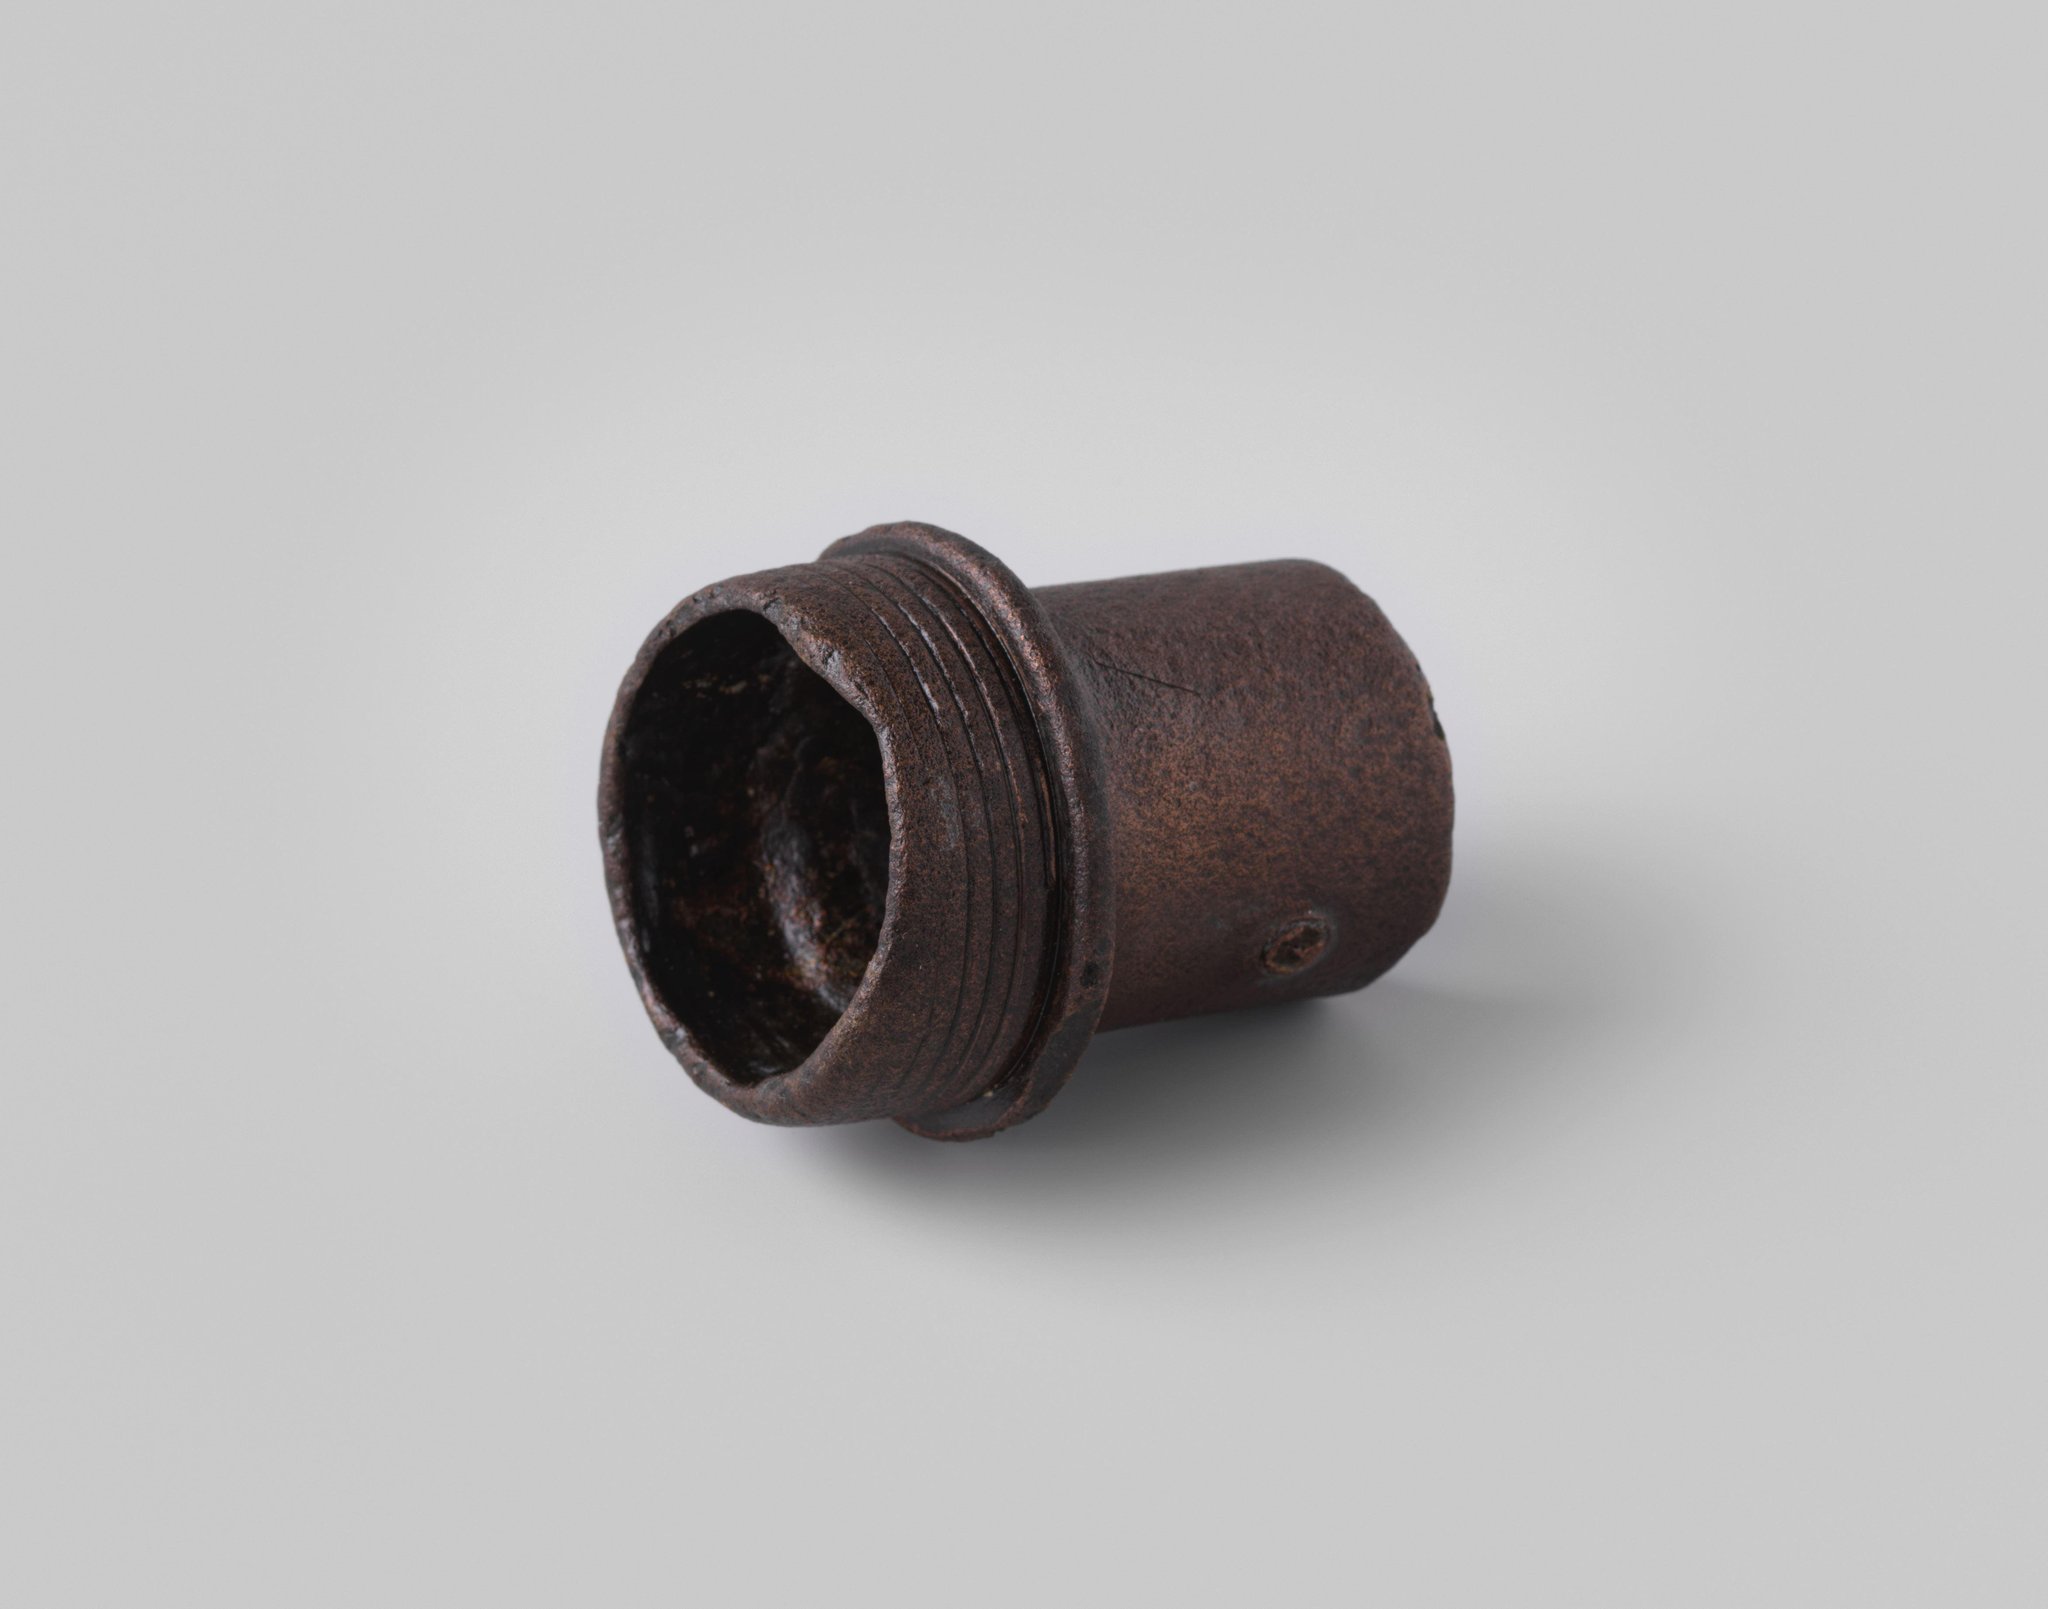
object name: firehose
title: Koppelstuk van een brandslang uit het wrak van de Oost-Indiëvaarder Hollandia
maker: Anonymous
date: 1700-1743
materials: copper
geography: netherlands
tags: verenigde oostindische compagnie, hollandia (schip), annet